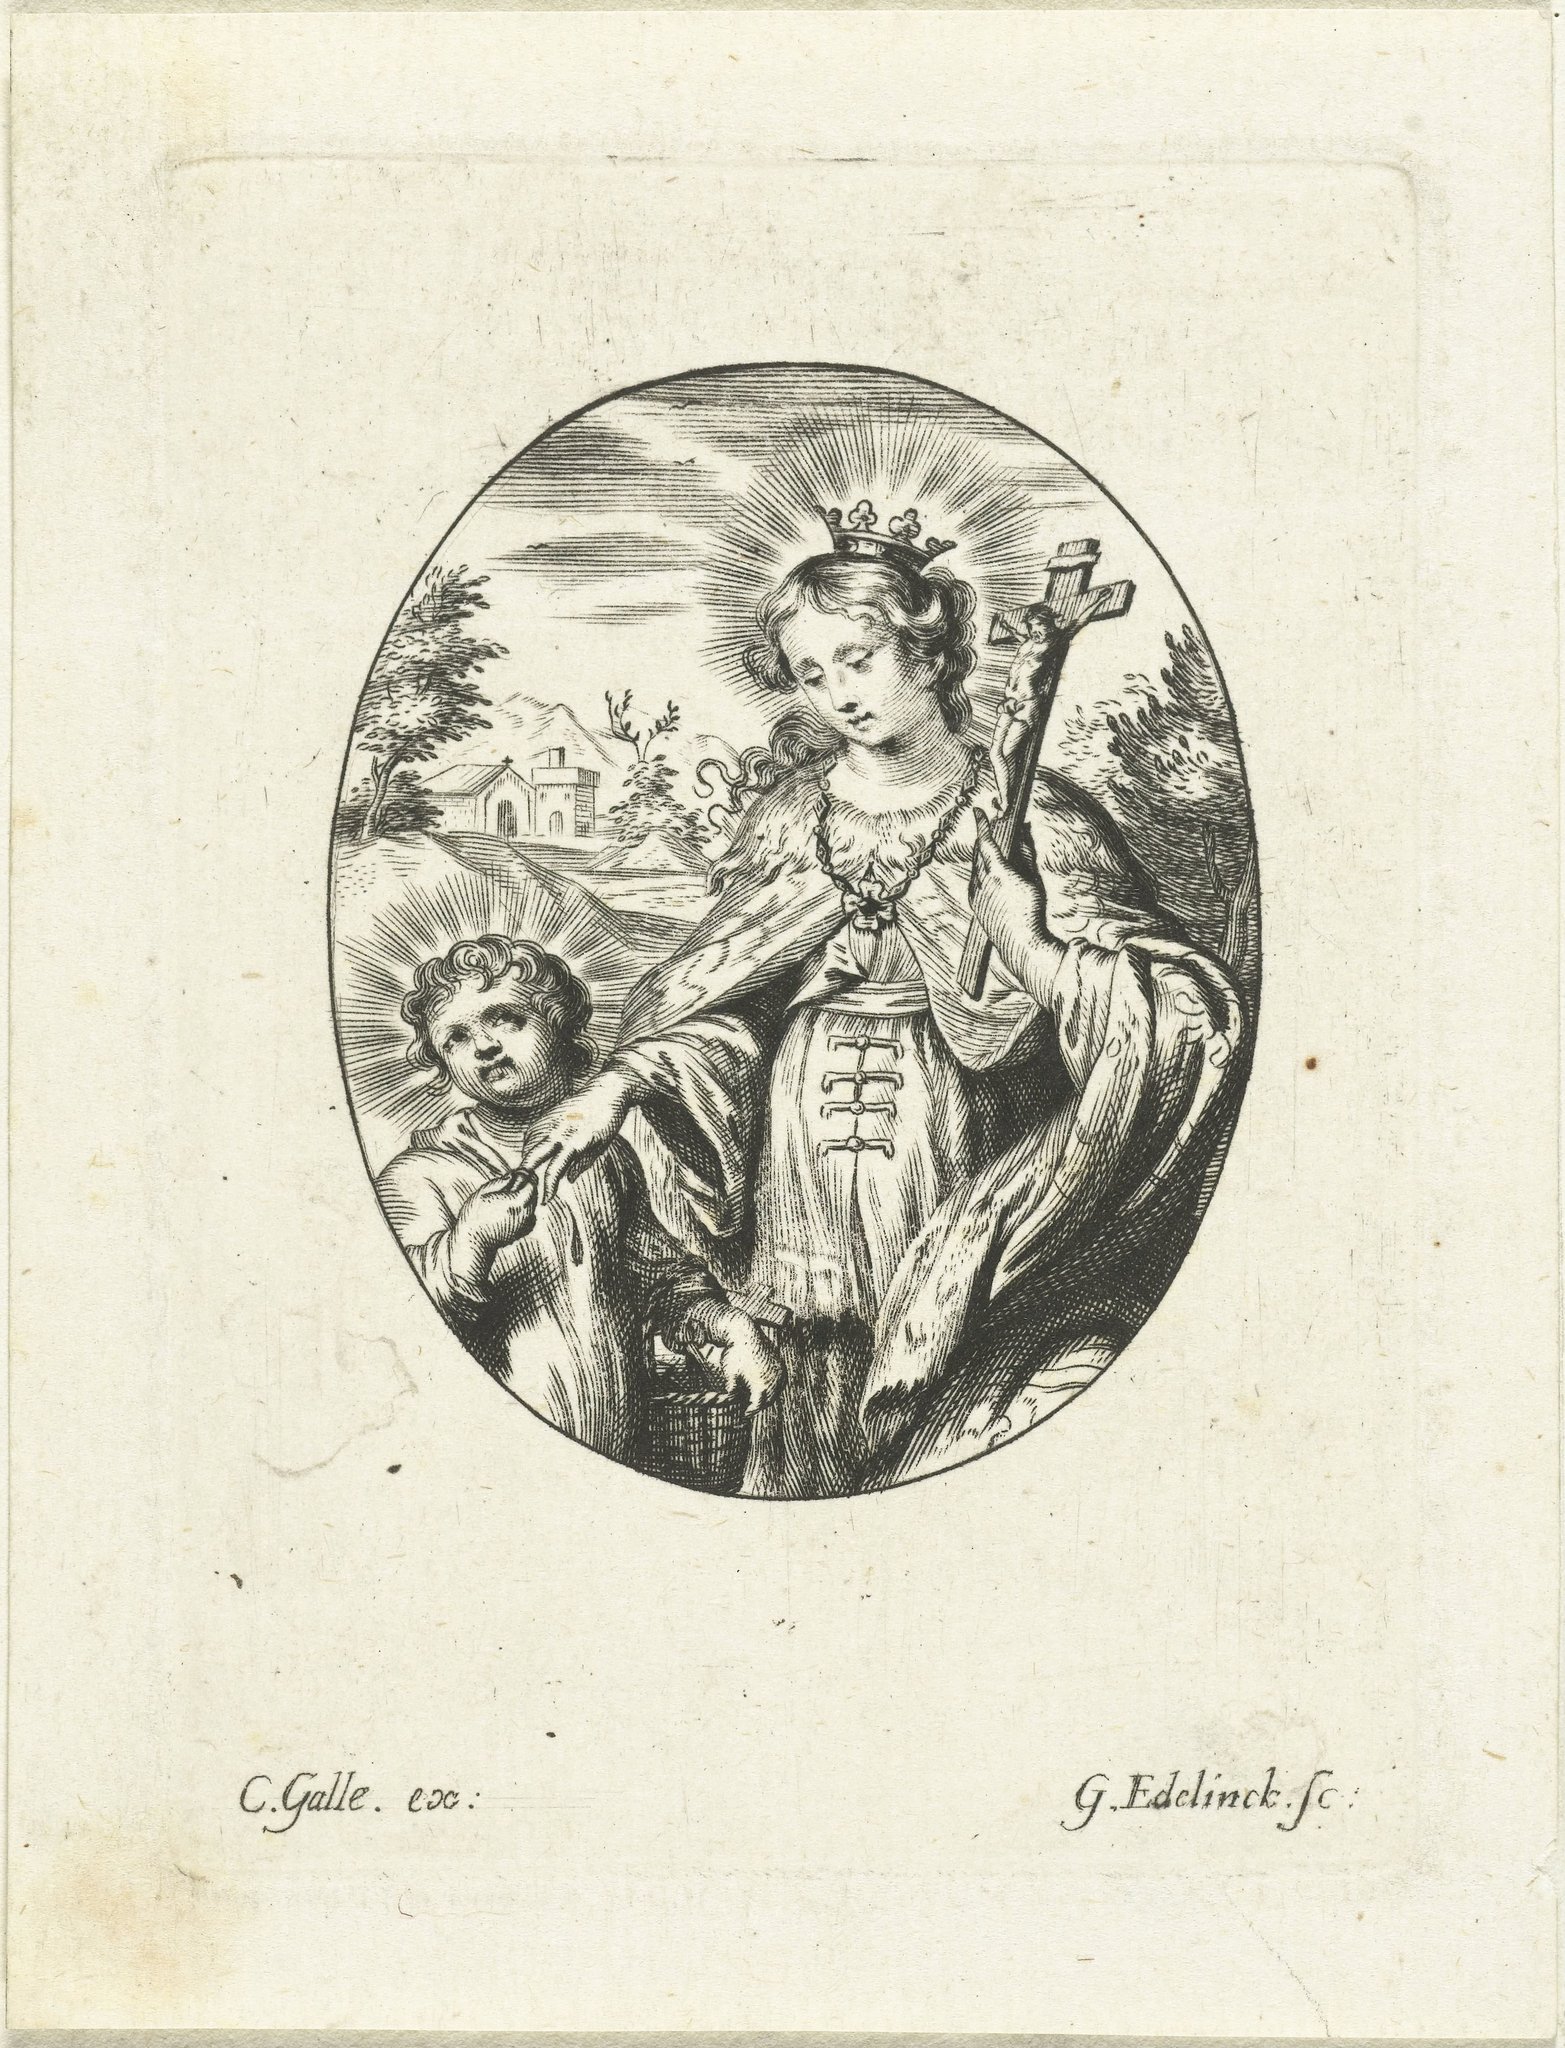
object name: print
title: Mystiek huwelijk van de heilige Catharina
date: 1652-1666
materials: paper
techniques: engraving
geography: antwerp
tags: the virgin martyr catherine of alexandria; possible attributes: book, crown, emperor maxentius, palm-branch, ring, sword, wheel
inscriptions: collector's mark: Lugt 240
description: De rijkelijk geklede Catharina van Alexandrië met kroon en crucifix, krijgt van het Christuskind een ring om haar vinger geschoven.